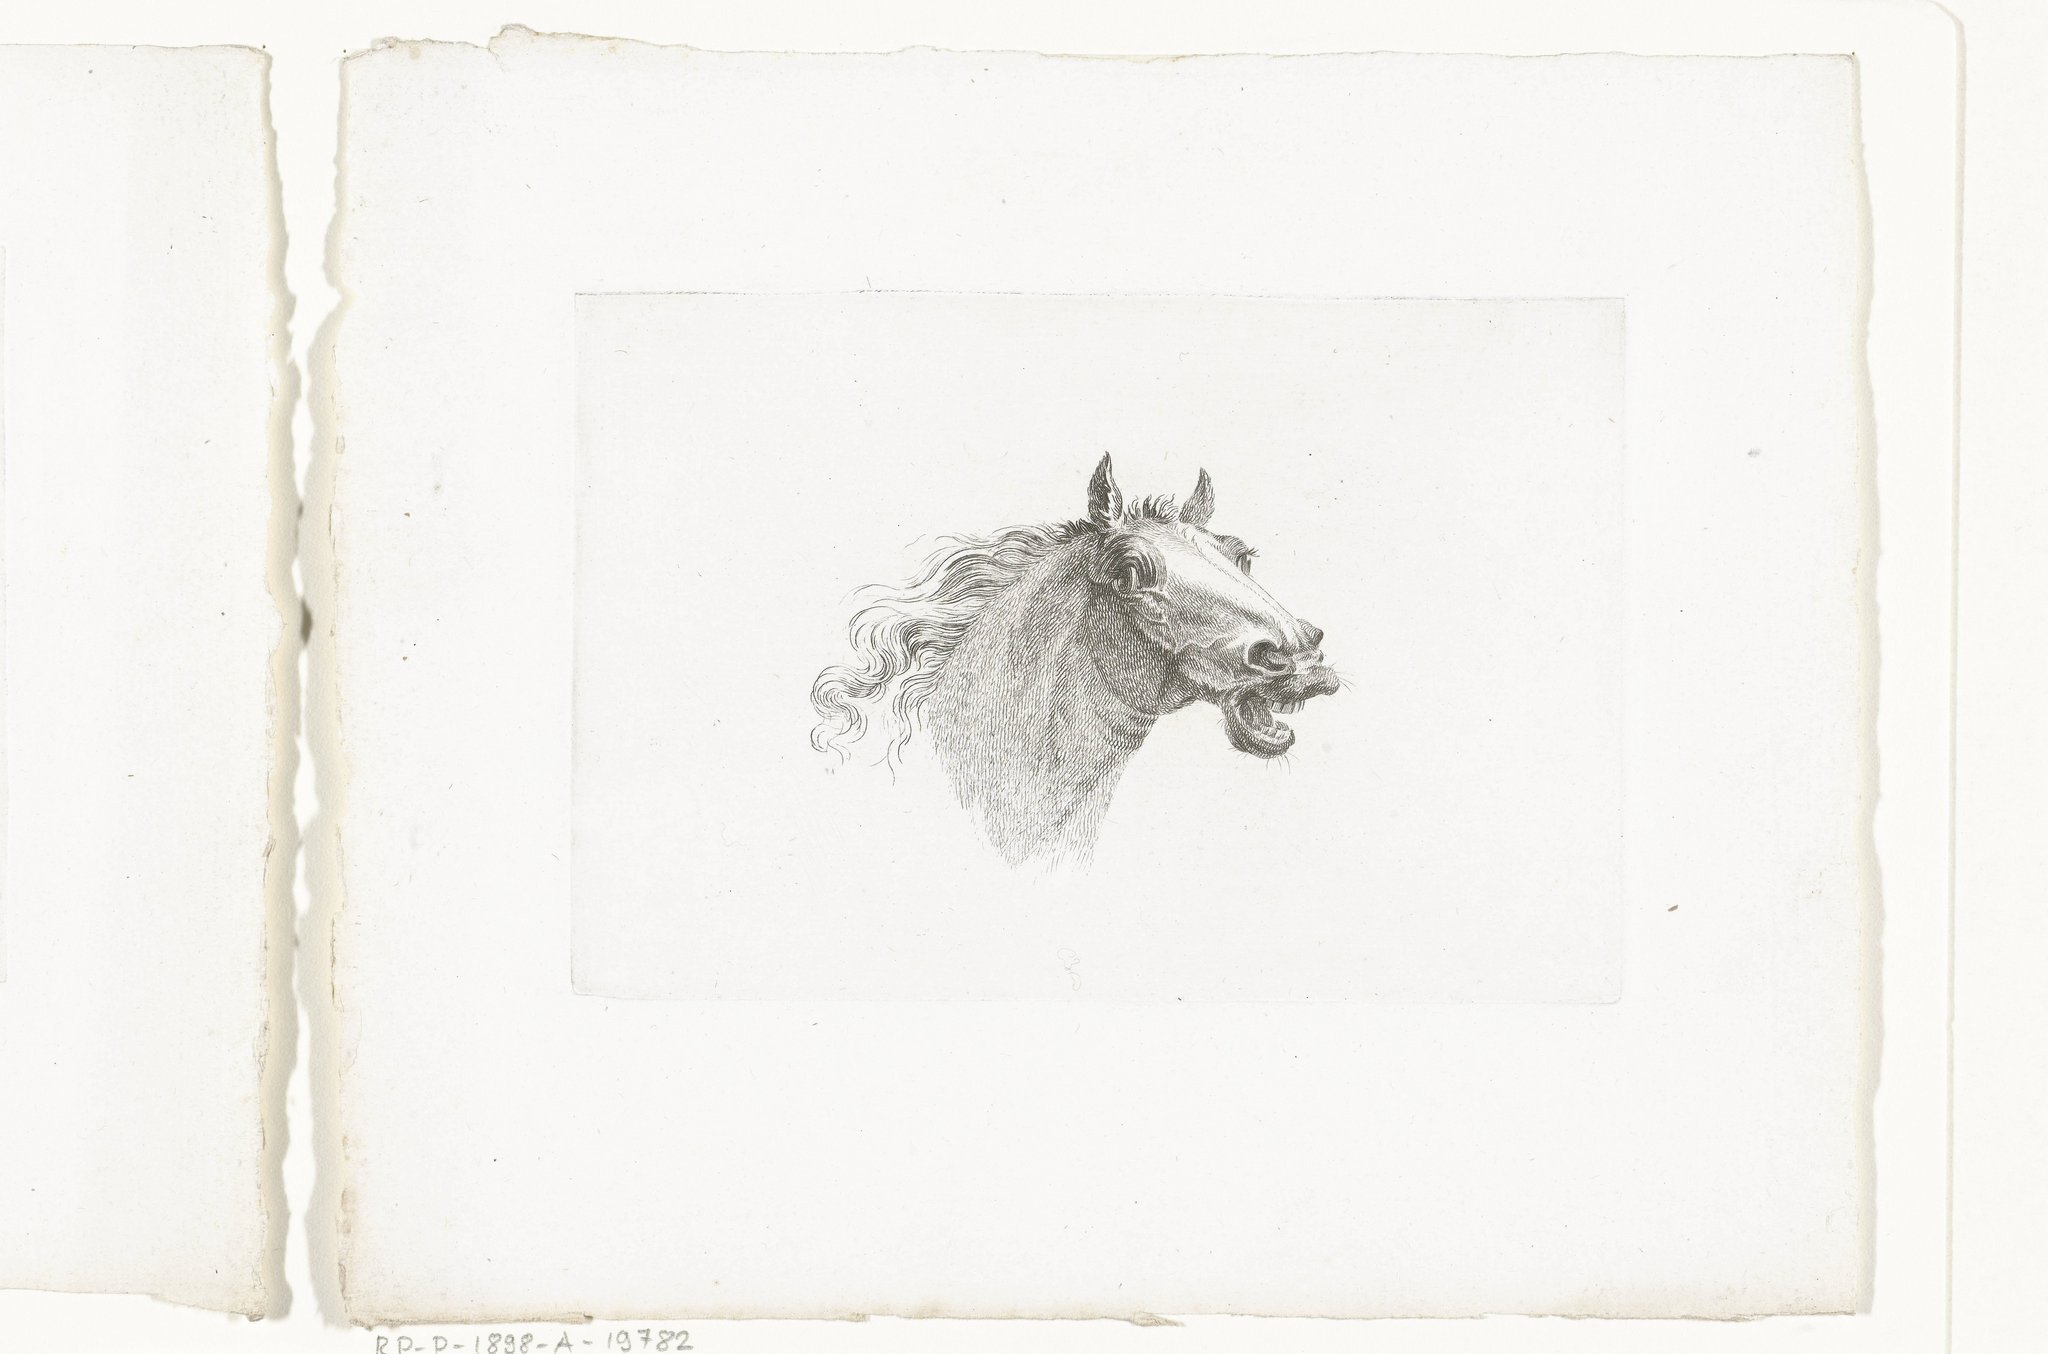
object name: print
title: Paardenhoofden naar Gerrit Malleyn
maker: joannes bemme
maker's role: print maker, printer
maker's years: 1775-1841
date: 1801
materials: paper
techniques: etching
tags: horse (+ head of an animal)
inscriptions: collector's mark: Lugt 2228